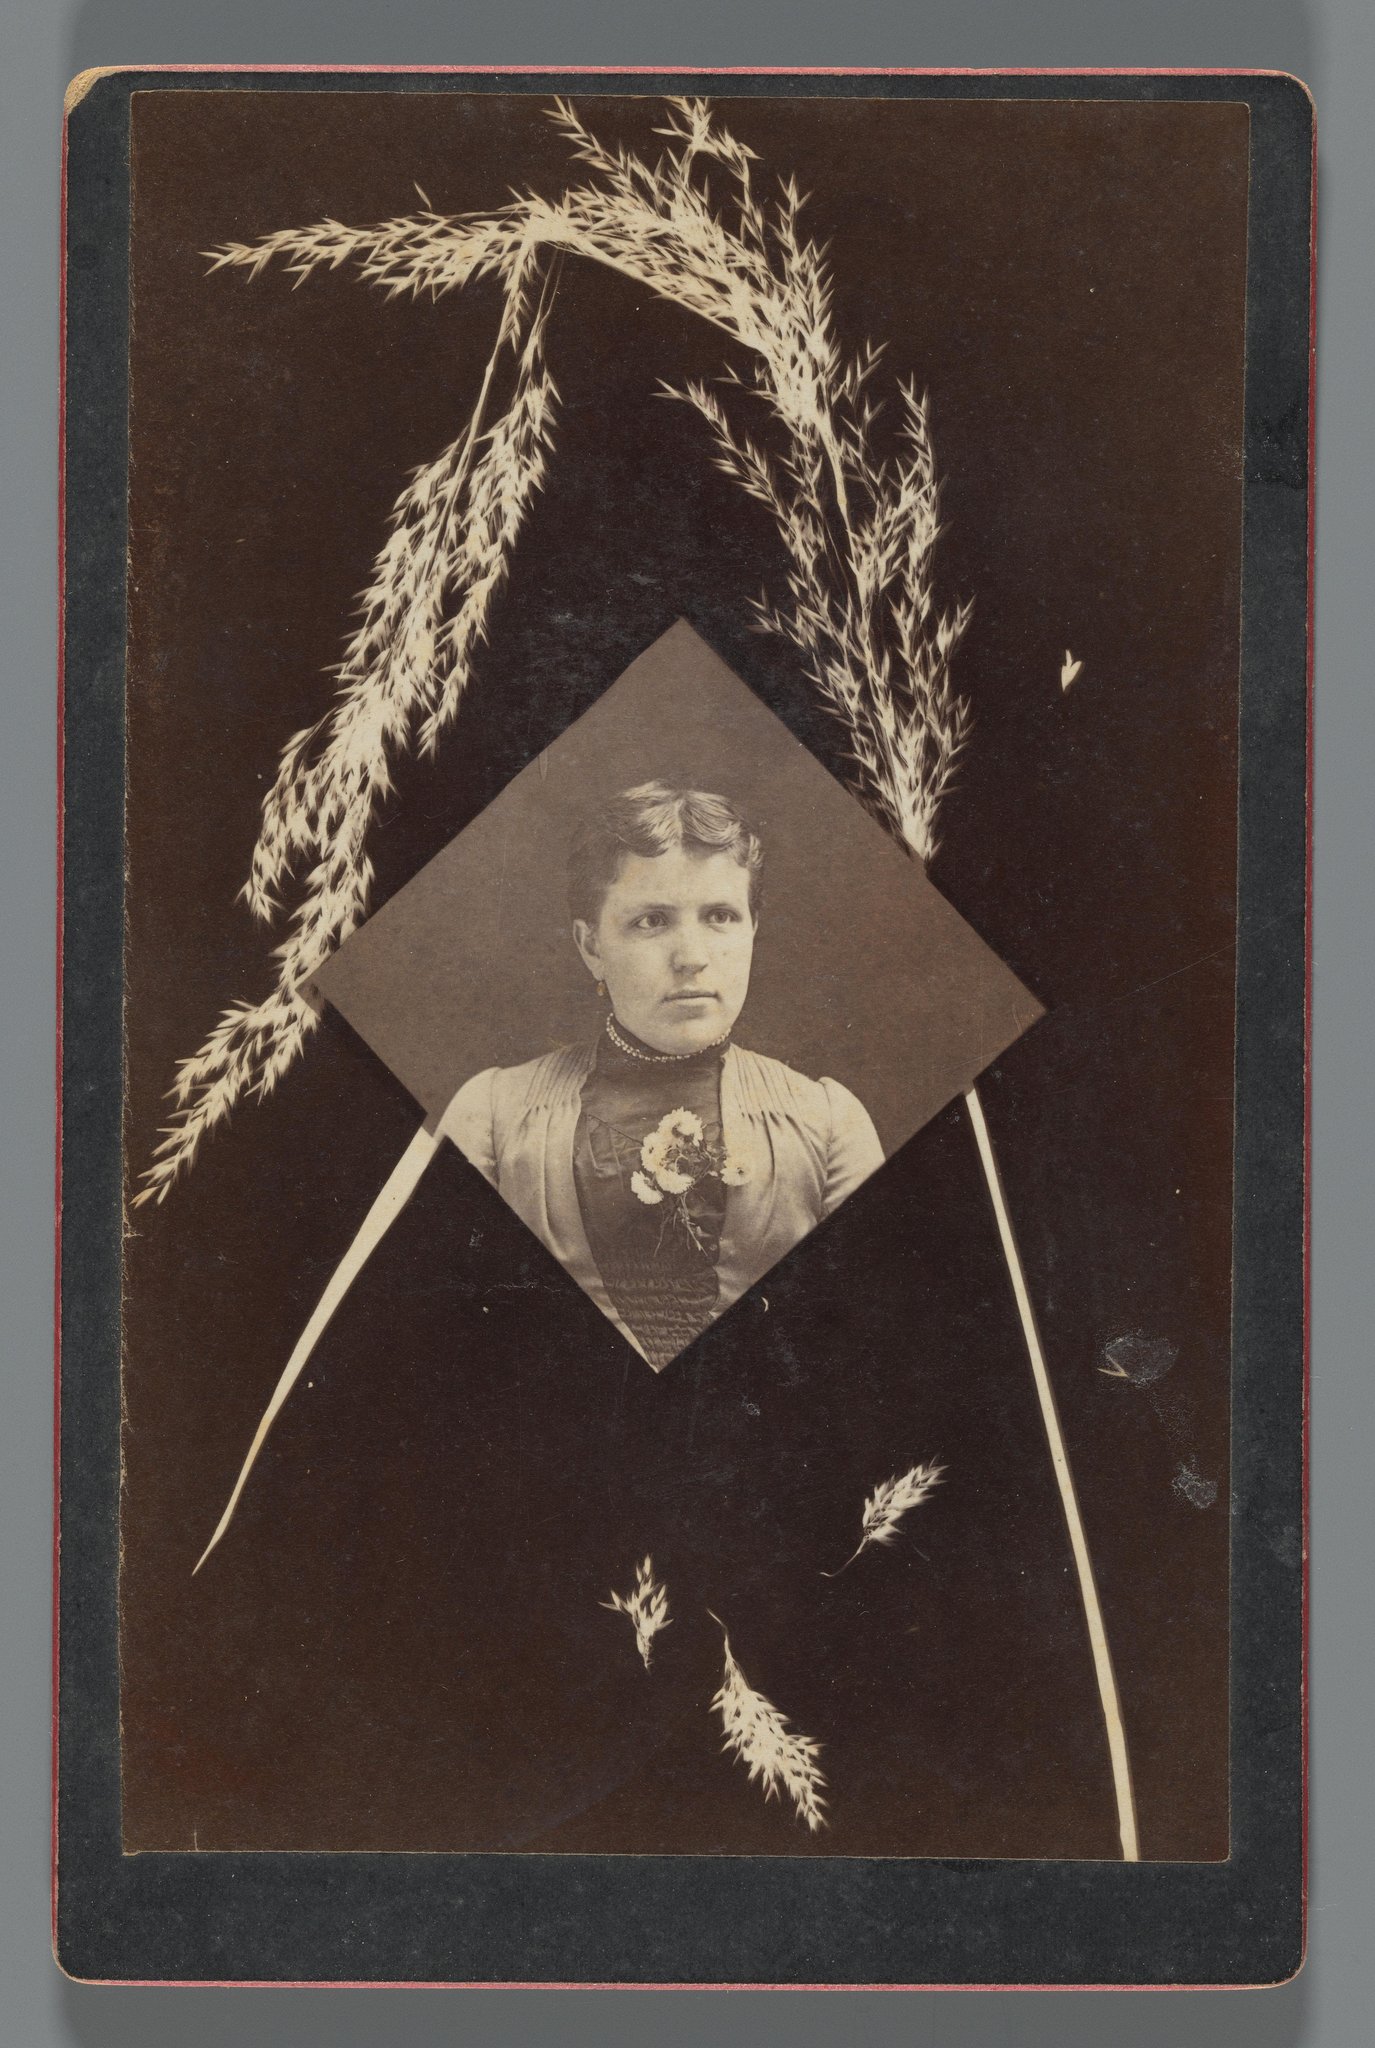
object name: cabinet photograph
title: Portret van een onbekende vrouw, omringd door fotogram van grashalmen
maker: Anonymous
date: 1890-1910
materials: cardboard, photographic support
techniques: photography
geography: united states